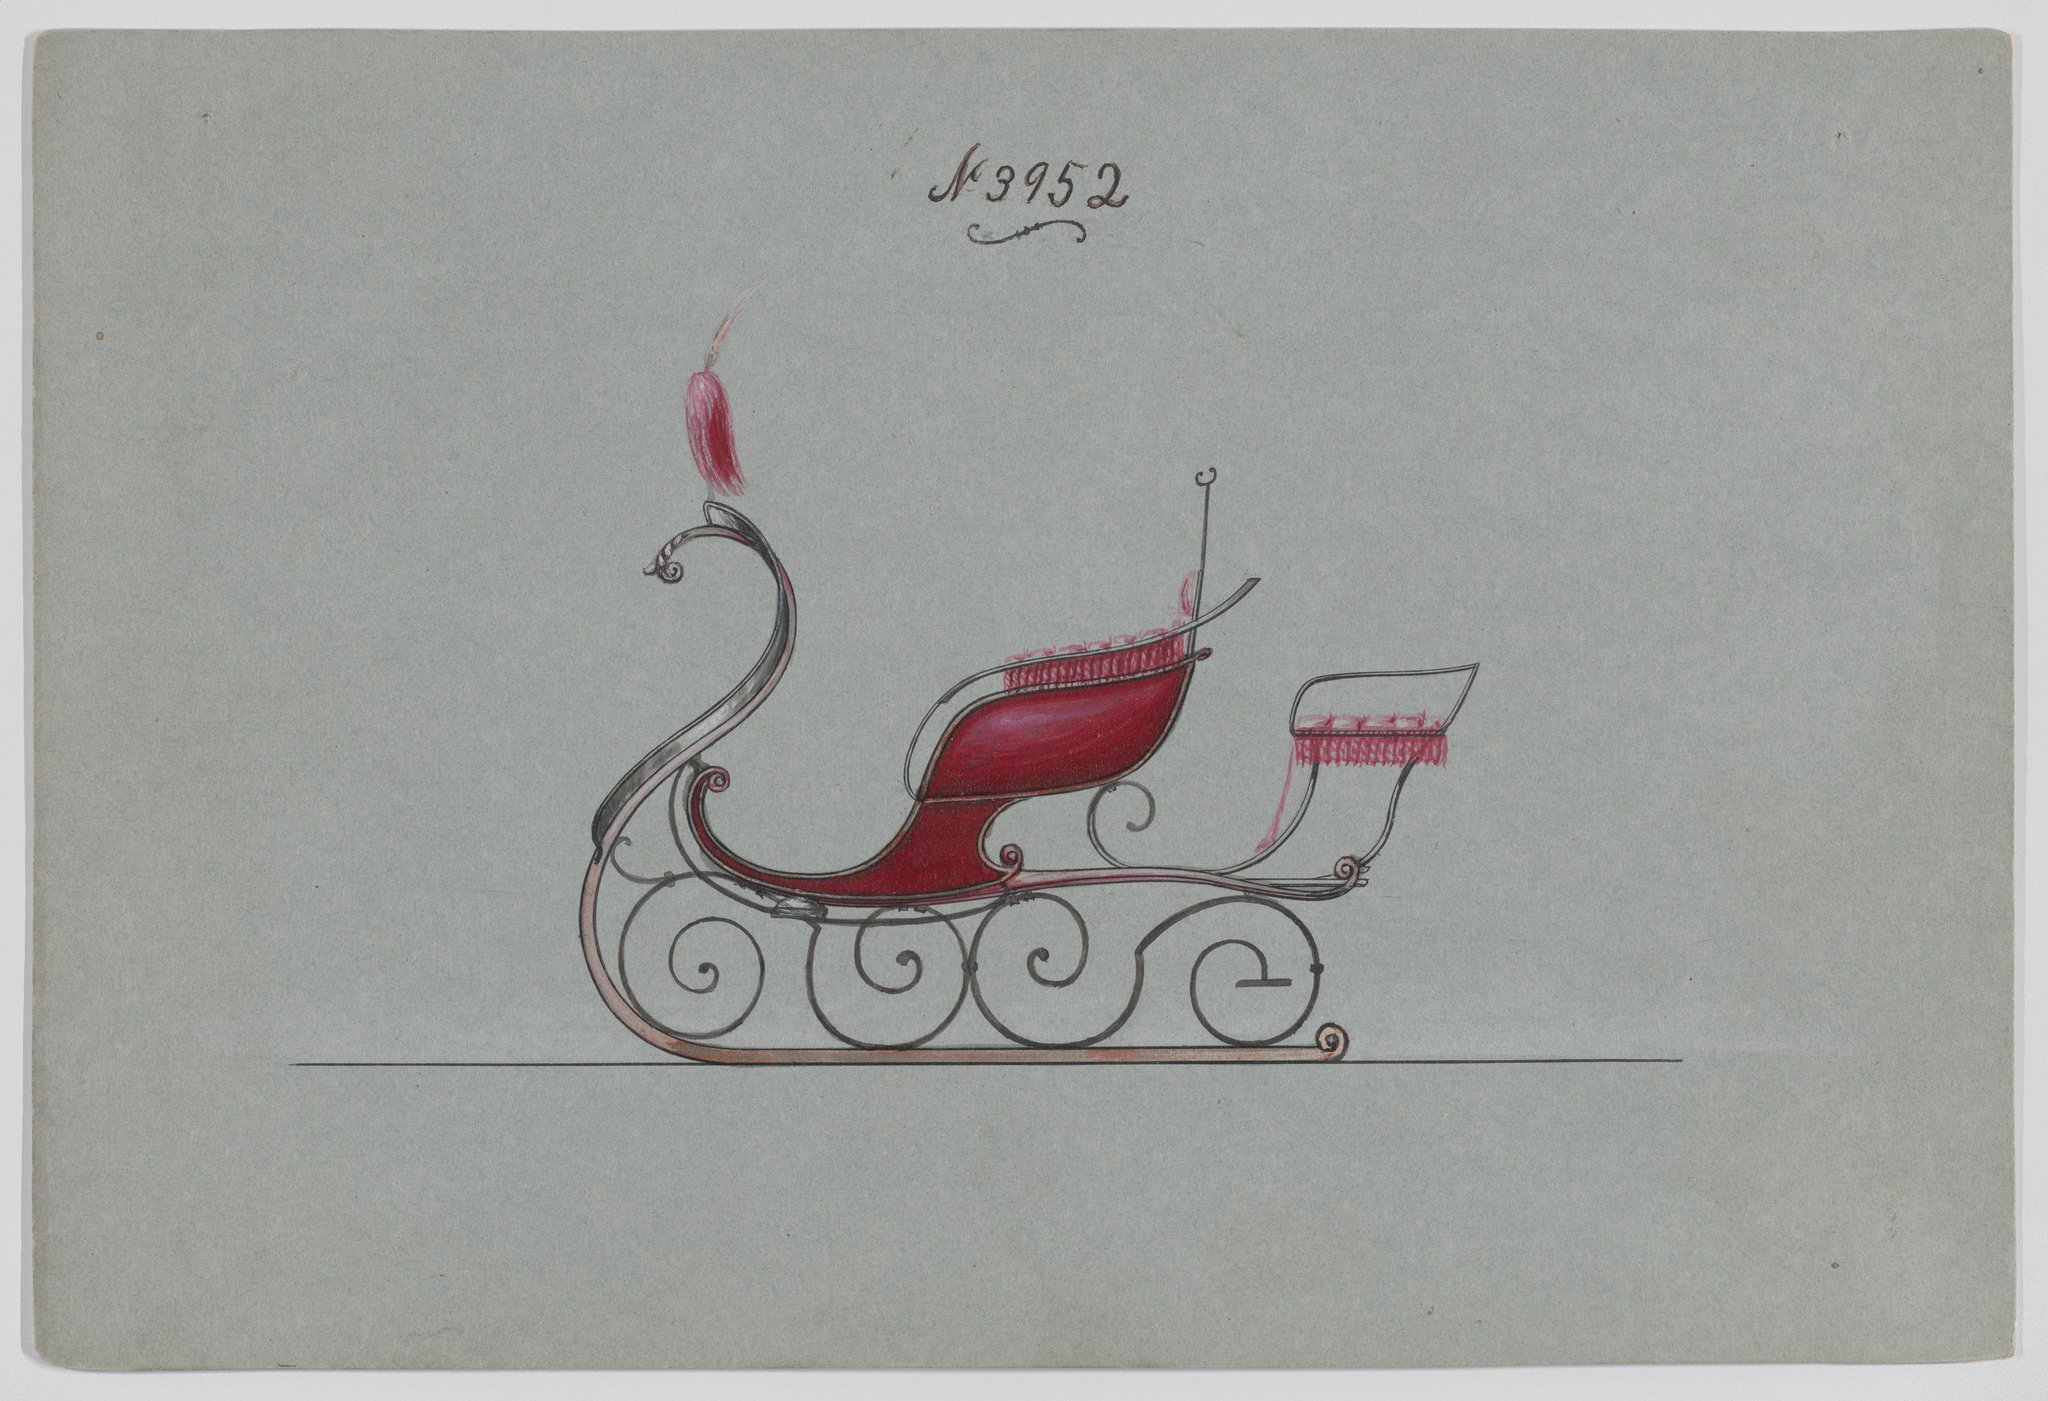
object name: drawing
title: Sleigh with Rumble Seat # 3952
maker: brewster & co.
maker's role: manufacturer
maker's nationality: american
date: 1885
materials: gouache, gum arabic, ink, watercolor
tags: sleighs